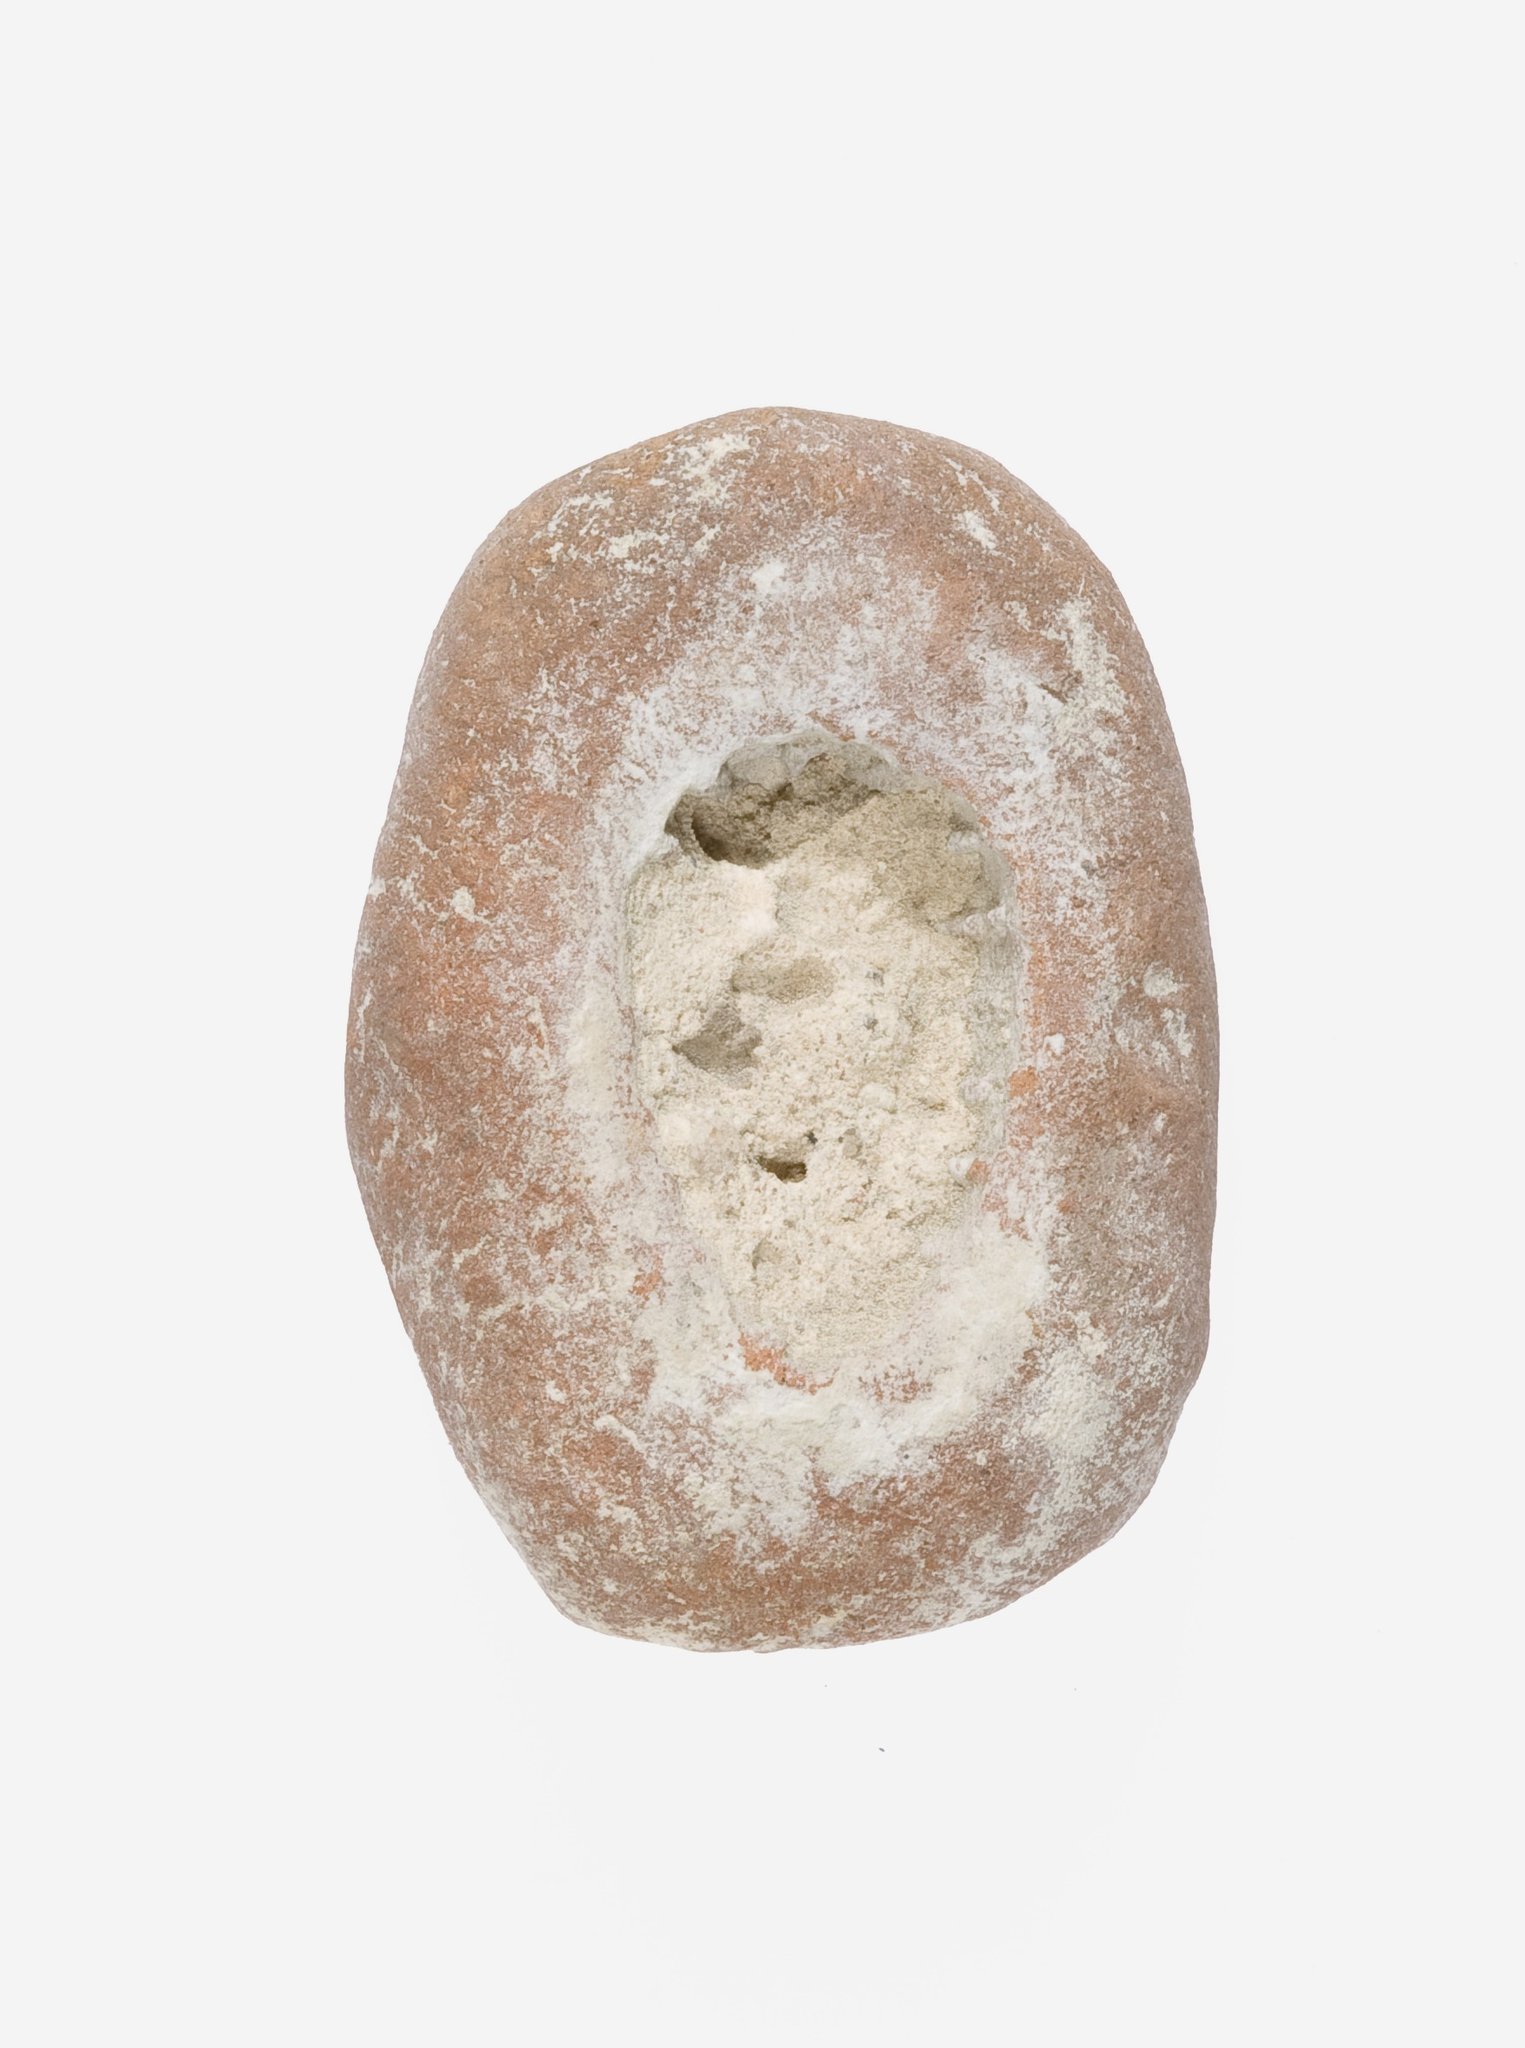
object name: mold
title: Mold for Ring or Pendant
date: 1390-1352 BCE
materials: pottery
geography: egypt